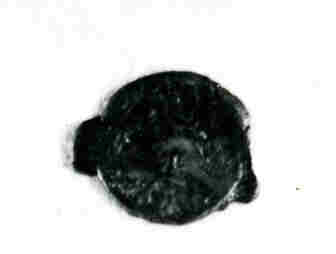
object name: coin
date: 401-1400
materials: copper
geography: iran